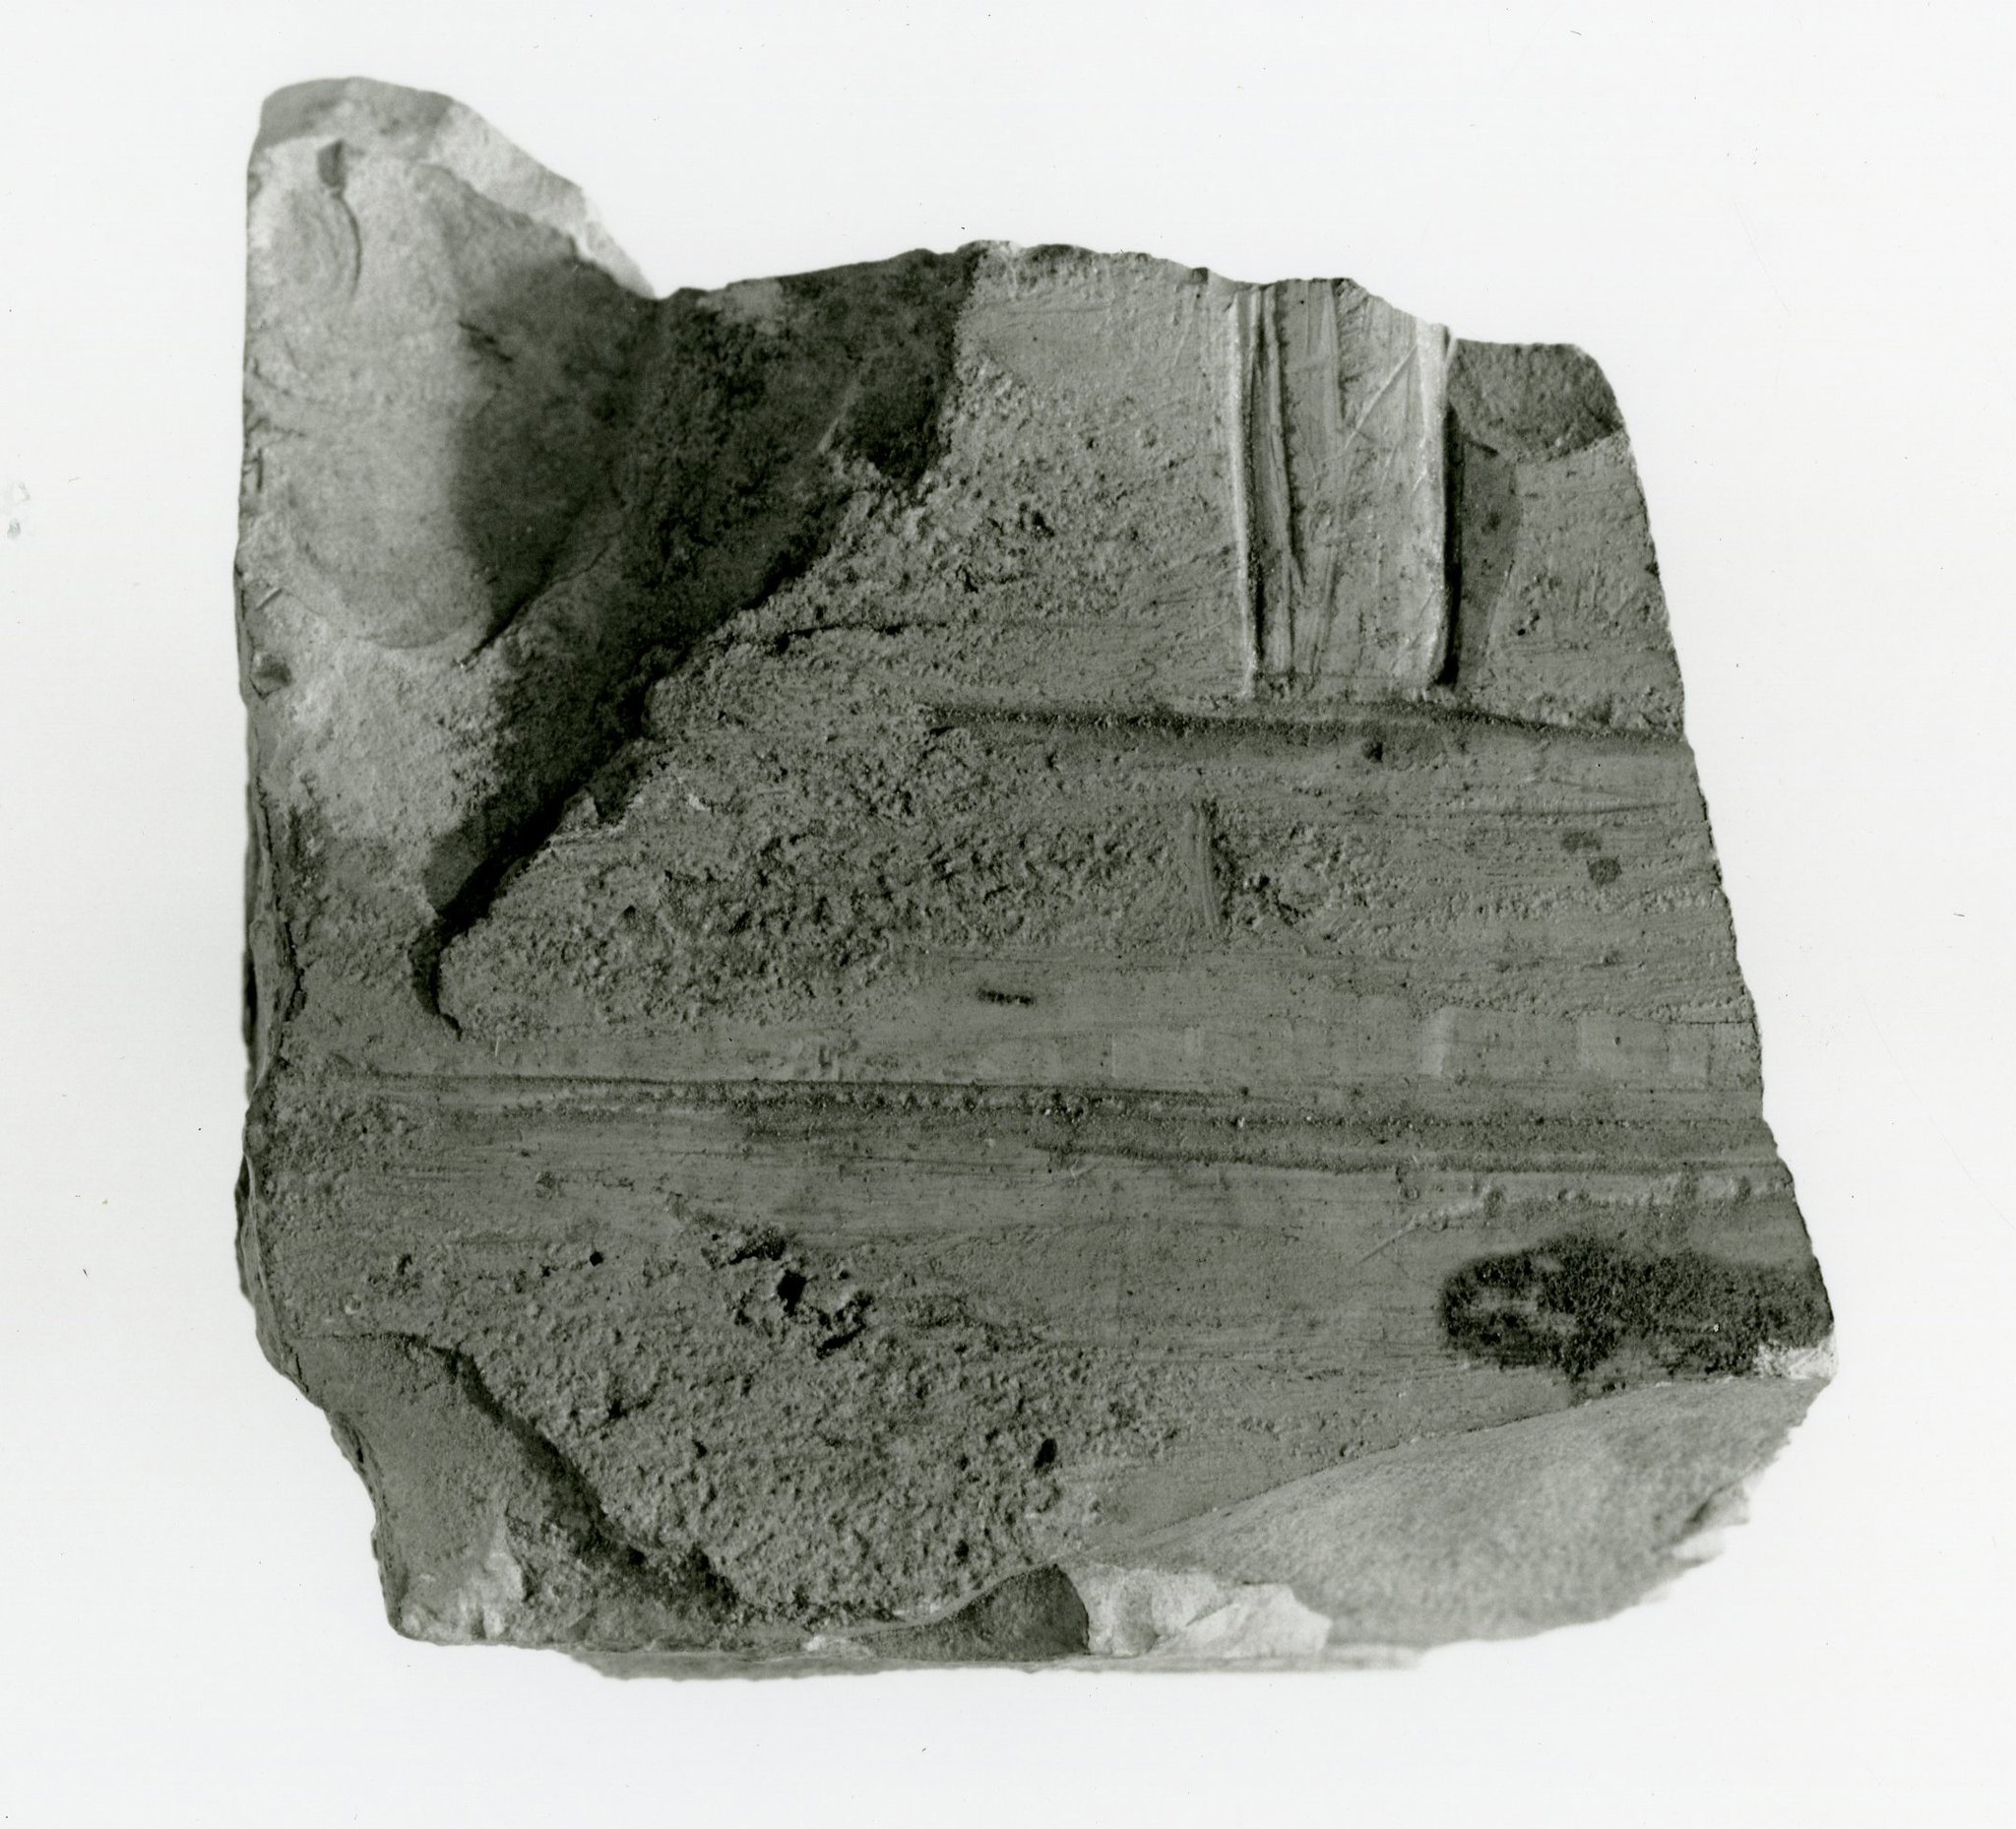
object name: relief, tomb of nespekashuty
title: Sunk relief fragment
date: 664-610 BCE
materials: limestone, mortar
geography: egypt